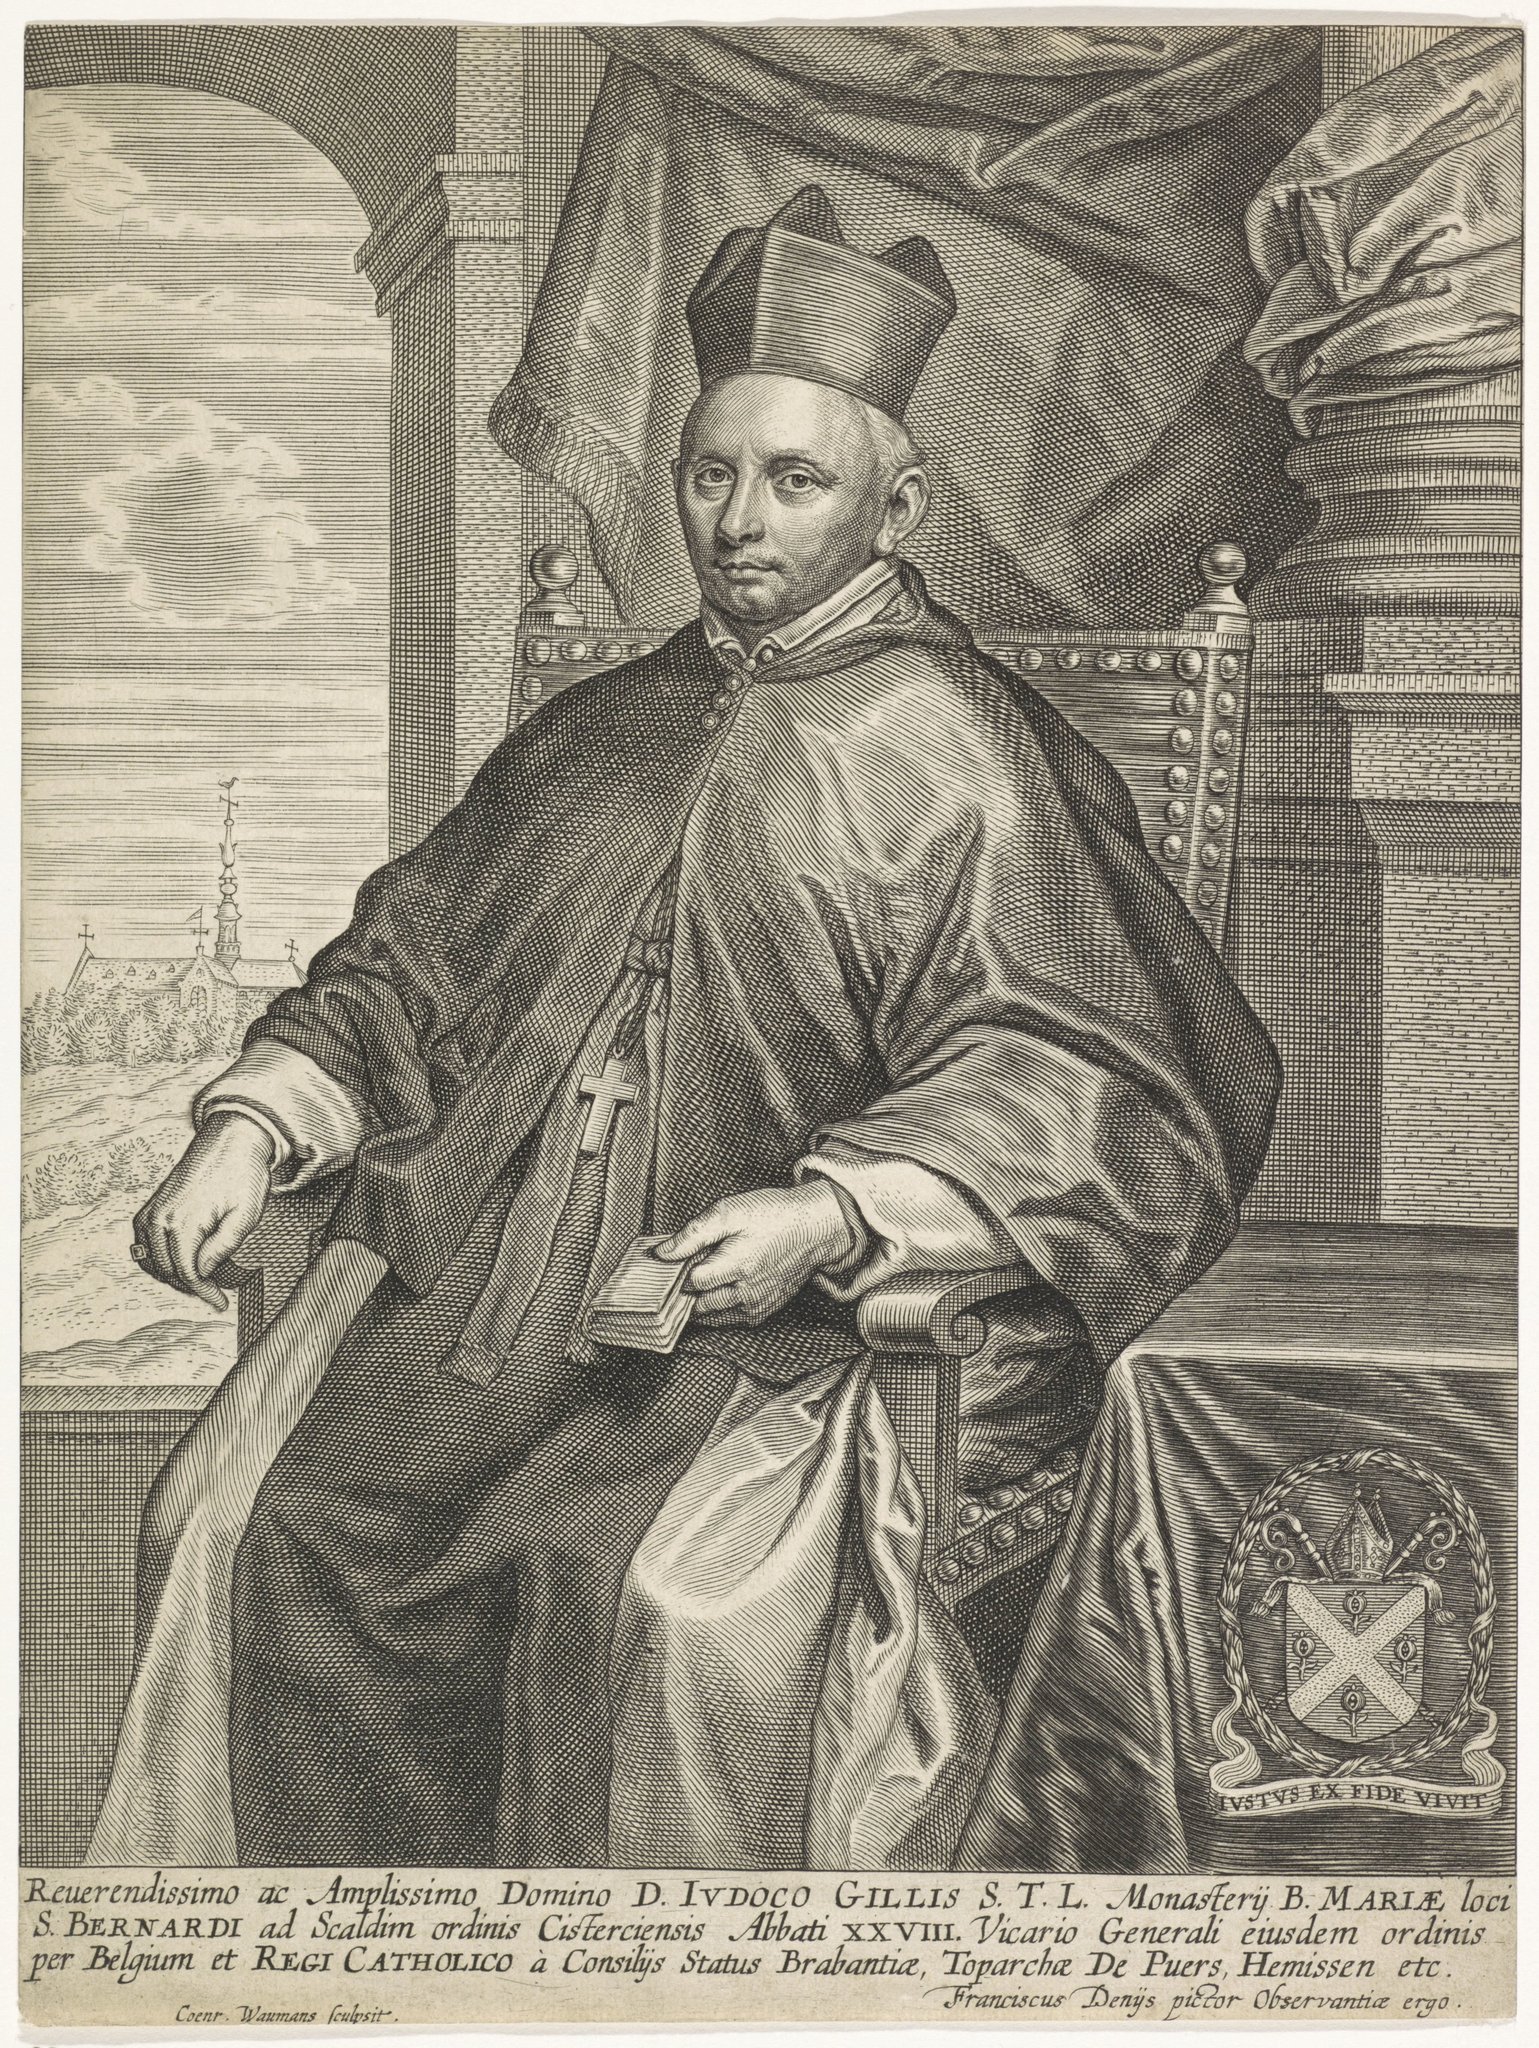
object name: print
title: Portret van abt Judocus Gillis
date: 1633-1673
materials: paper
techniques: engraving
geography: antwerp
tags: judocus gillis, church (exterior), armorial bearing, heraldry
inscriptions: collector's mark: Lugt 2228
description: Portret van abt Judocus Gillis. Links door het venster een gezicht op een kerk. Rechtsonder zijn wapenschild en devies in het Latijn. In de marge een drieregelig onderschrift in het Latijn.